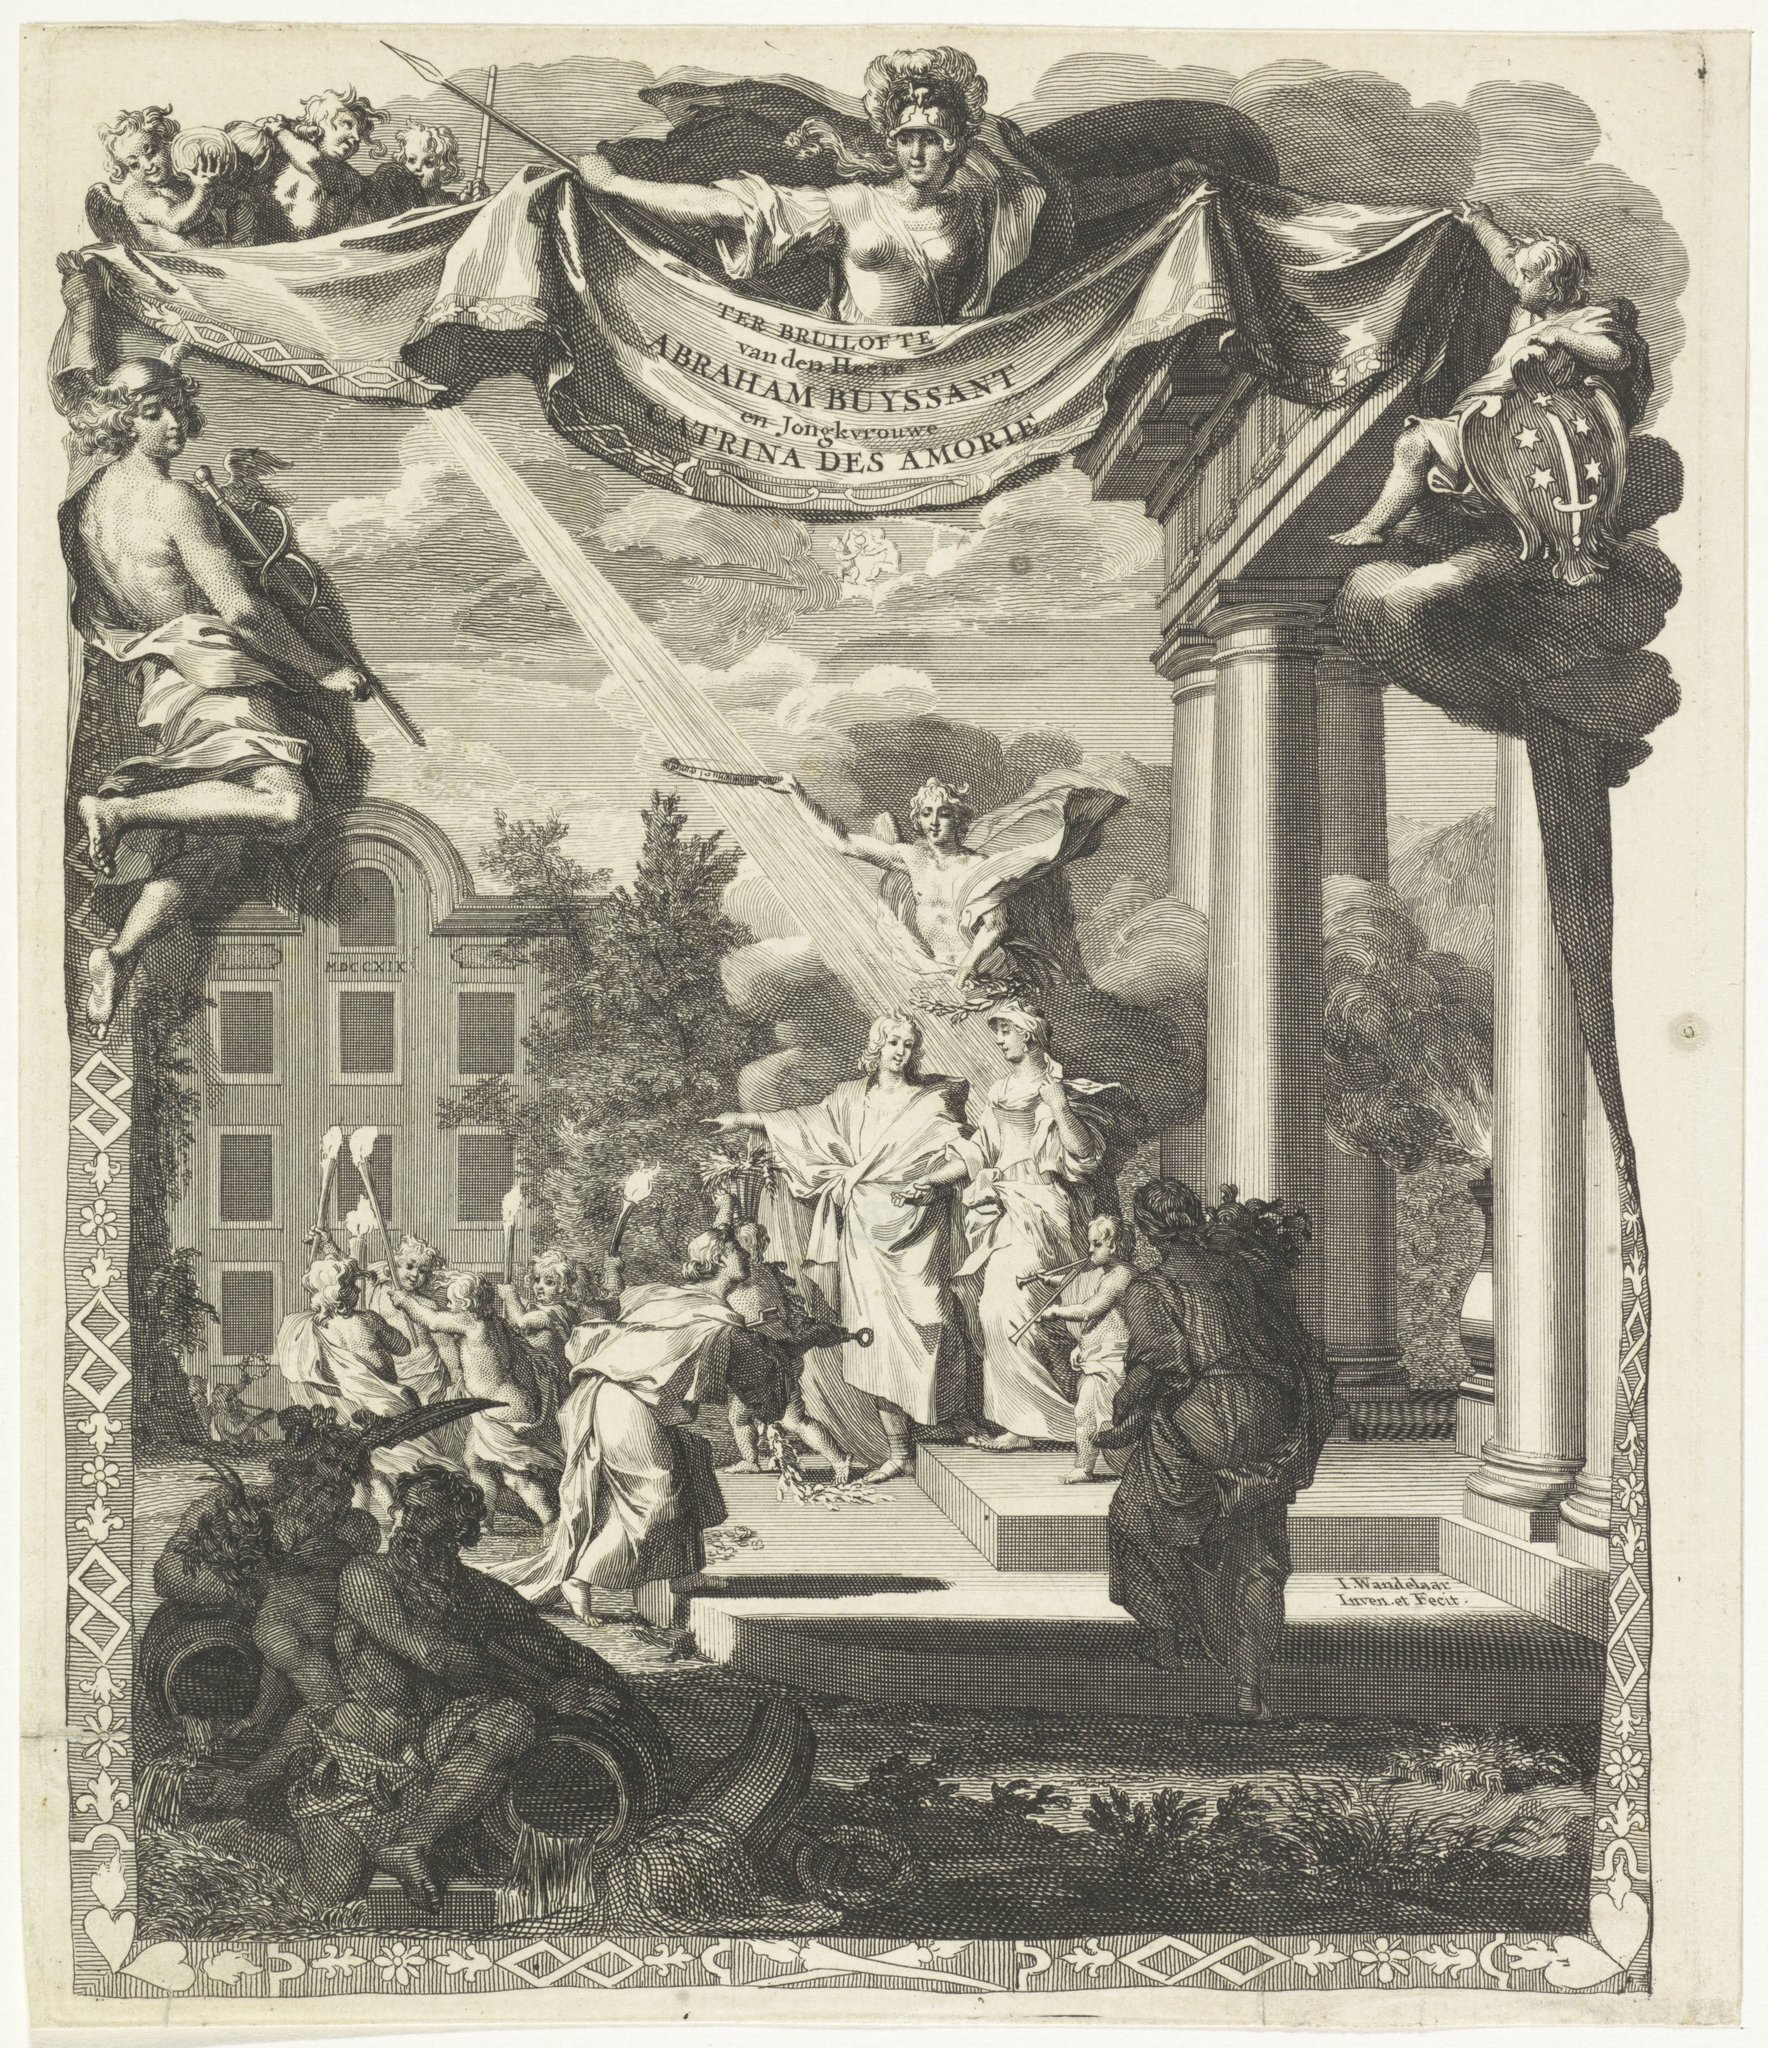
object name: print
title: Allegorische voorstelling ter gelegenheid van het huwelijk van Abraham Buyssant en Catharina des Amorie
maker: jan wandelaar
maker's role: draughtsman, print maker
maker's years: 1690-1759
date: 1720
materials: paper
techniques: engraving, etching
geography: northern netherlands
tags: title-page, marriage, married couple, 'matrimonium', specific aspects, allegorical aspects of minerva; minerva as patroness, specific aspects, allegorical aspects of mercury; mercury as patron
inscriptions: collector's mark: Lugt 2760, collector's mark: Lugt 2228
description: Het huwelijkspaar staat op de trappen van een klassiek gebouw. Ze worden met een lauwerkrans gekroond door Hymenaeus die boven hen een stralenbundel door een ring als symbool van verbondenheid laat schijnen. Voor het paar staan putti met blaasinstrumenten en brandende fakkels, symbolen van liefde. De vrouw links, waarschijnlijk de personificatie van trouw, biedt het paar twee sleutels aan. De rechter vrouw houdt een hoorn des overvloeds vast. Linksvoor zitten twee stroomgoden. De voorstelling is in een ornamentele omlijsting met onder andere fakkels en brandende harten gevat. Boven de voorstelling houdt Minerva een draperie met de namen van Abraham Buyssant en Catharina des Amorie vast. Linksboven is Mercurius weergegeven en rechts zit een putto met een familiewapen. Het huwelijk vond plaats op 16 juni 1720 te Haarlem.